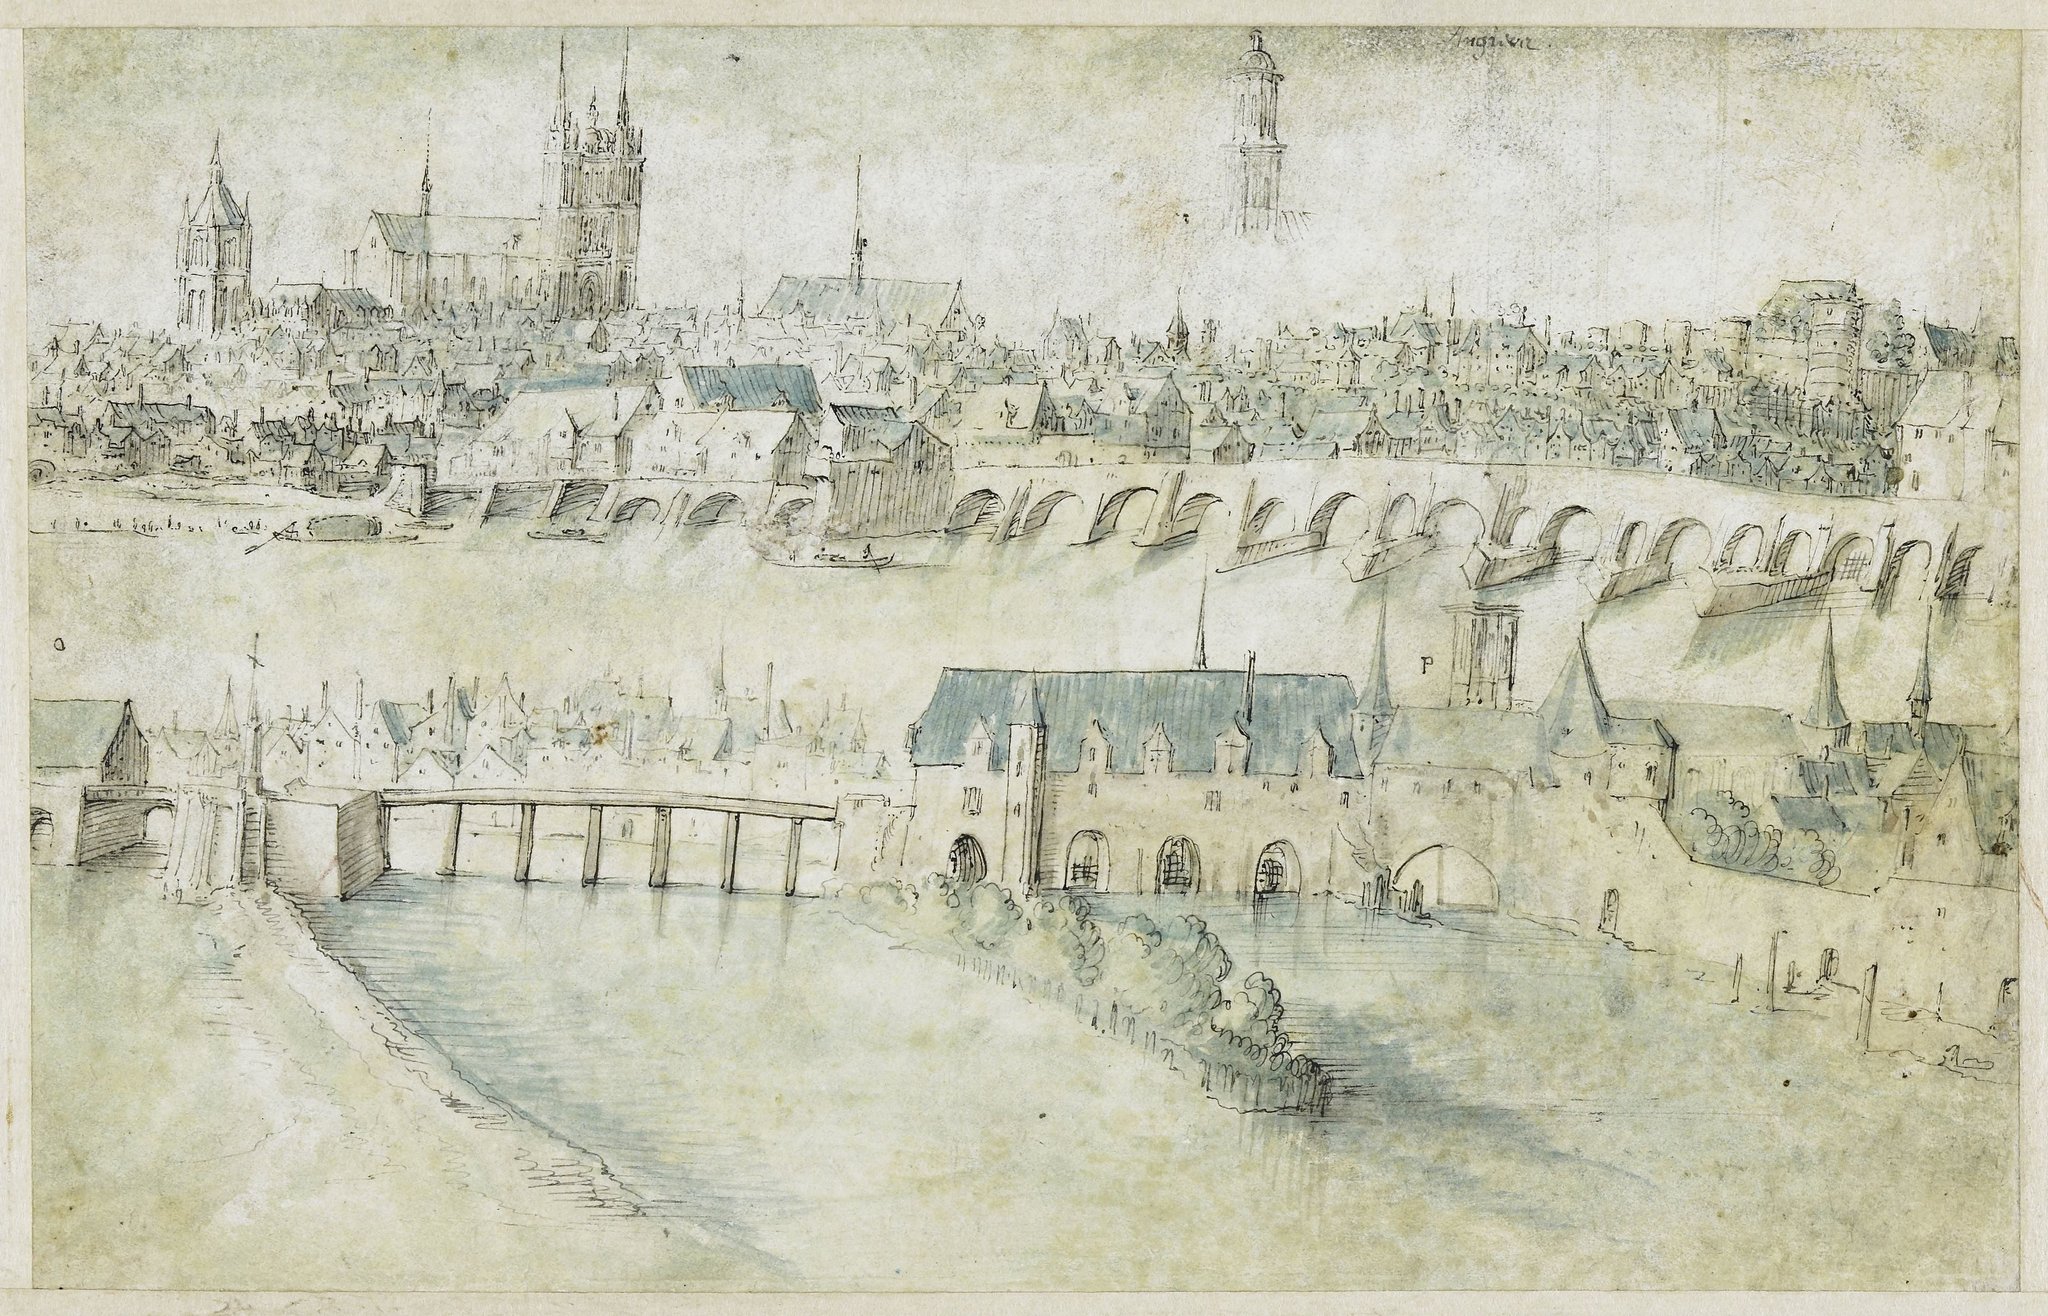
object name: drawing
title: Stad Angers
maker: Anonymous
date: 1600-1650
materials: ink, parchment, watercolor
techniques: brush, pen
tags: bridge in city across river, canal, etc. (+ city(-scape) with figures, staffage), prospect of city, town panorama, silhouette of city